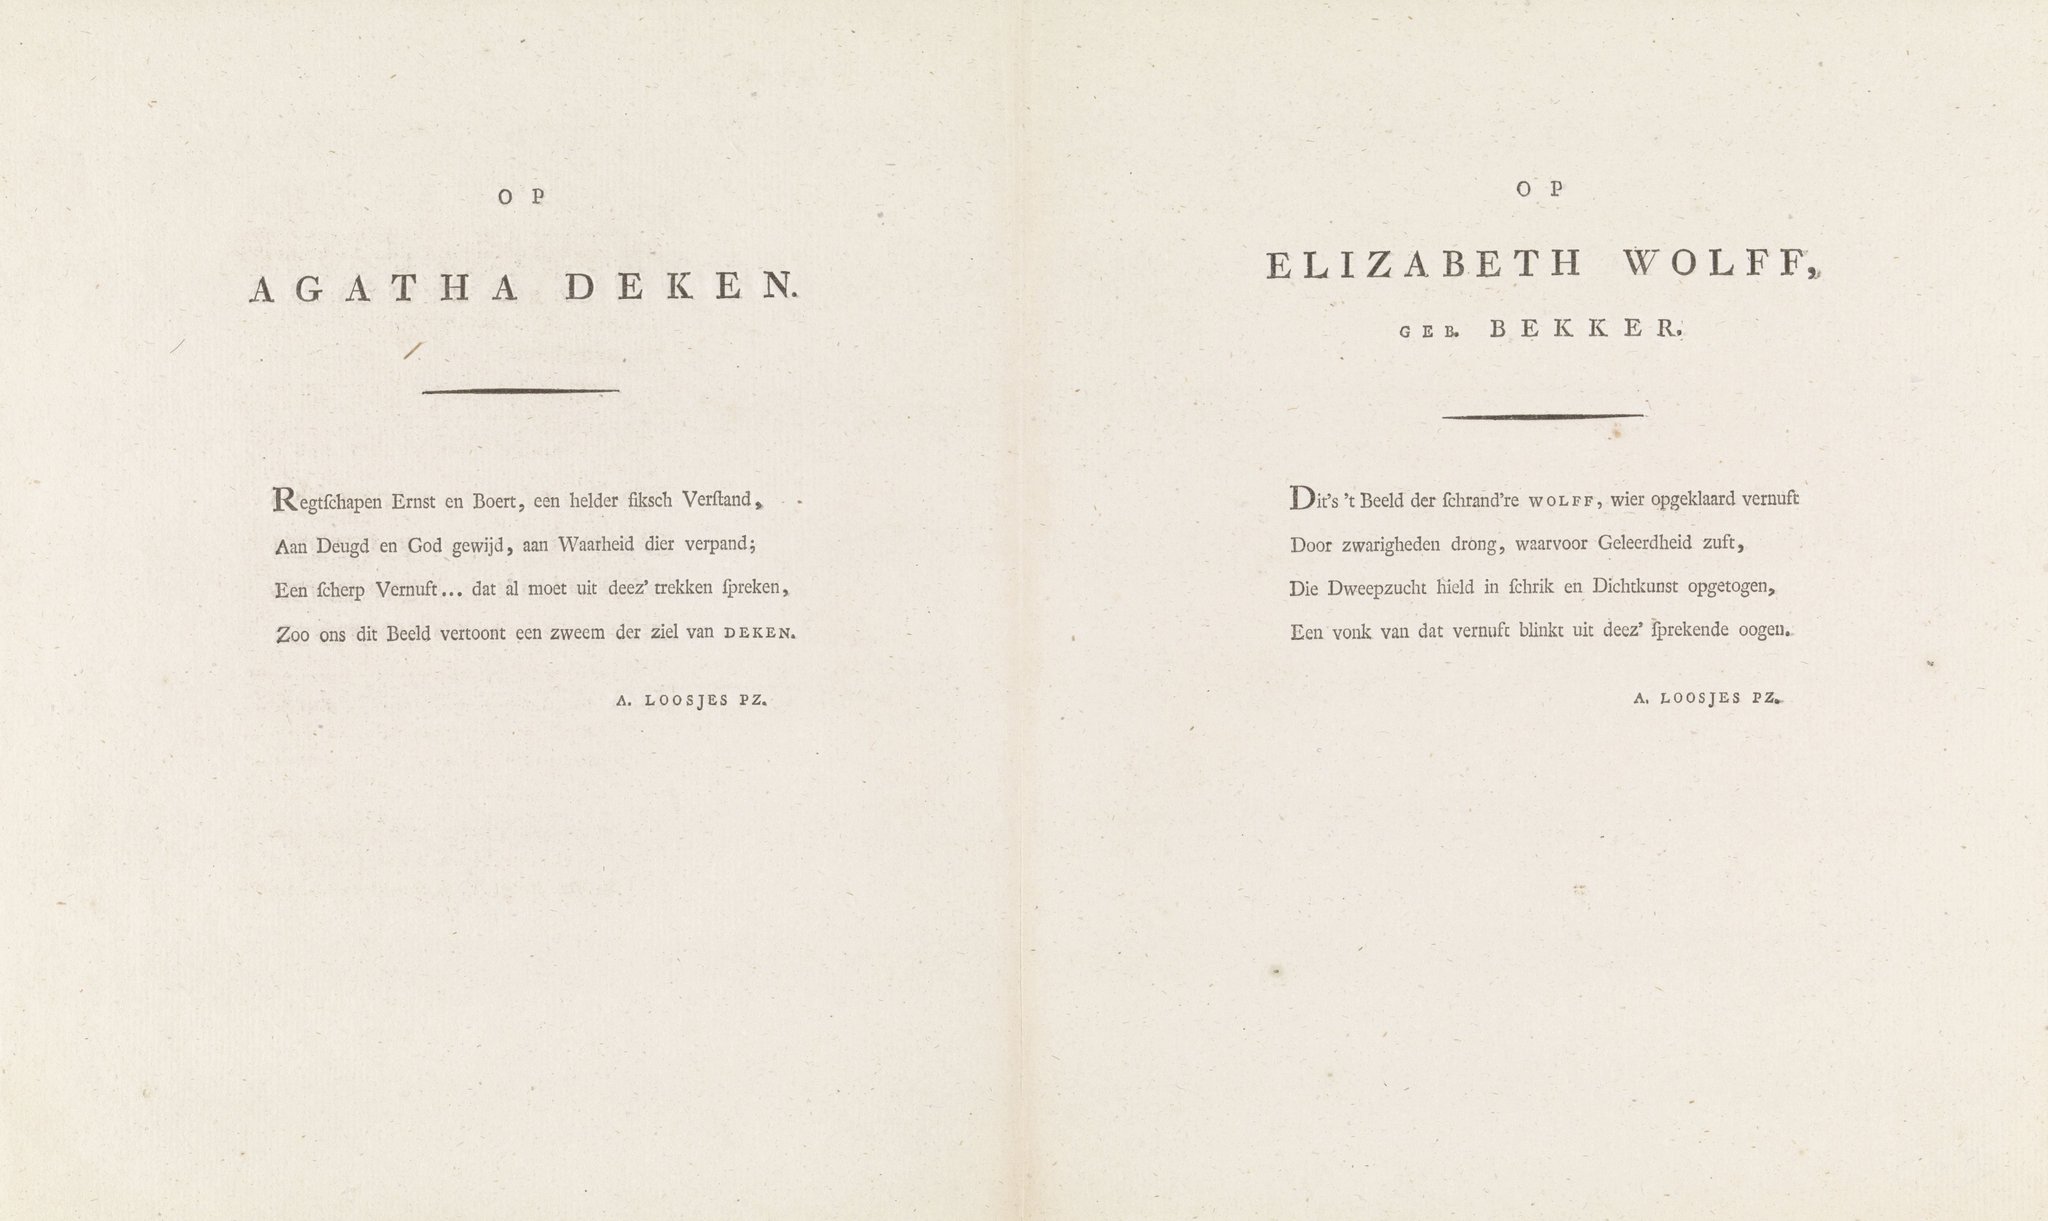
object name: wrapper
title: Omslag met twee gedichten op Agatha Deken en Elizabeth Wolff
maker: adriaan pietersz. loosjes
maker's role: bookseller, publisher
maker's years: 1761-1818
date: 1783-1818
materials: paper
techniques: letterpress printing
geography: amsterdam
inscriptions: collector's mark: Lugt 2228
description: Een vierregelig lofdicht in het Nederlands op de dichteressen Agatha Deken (links) en Elizabeth Wolff (rechts).